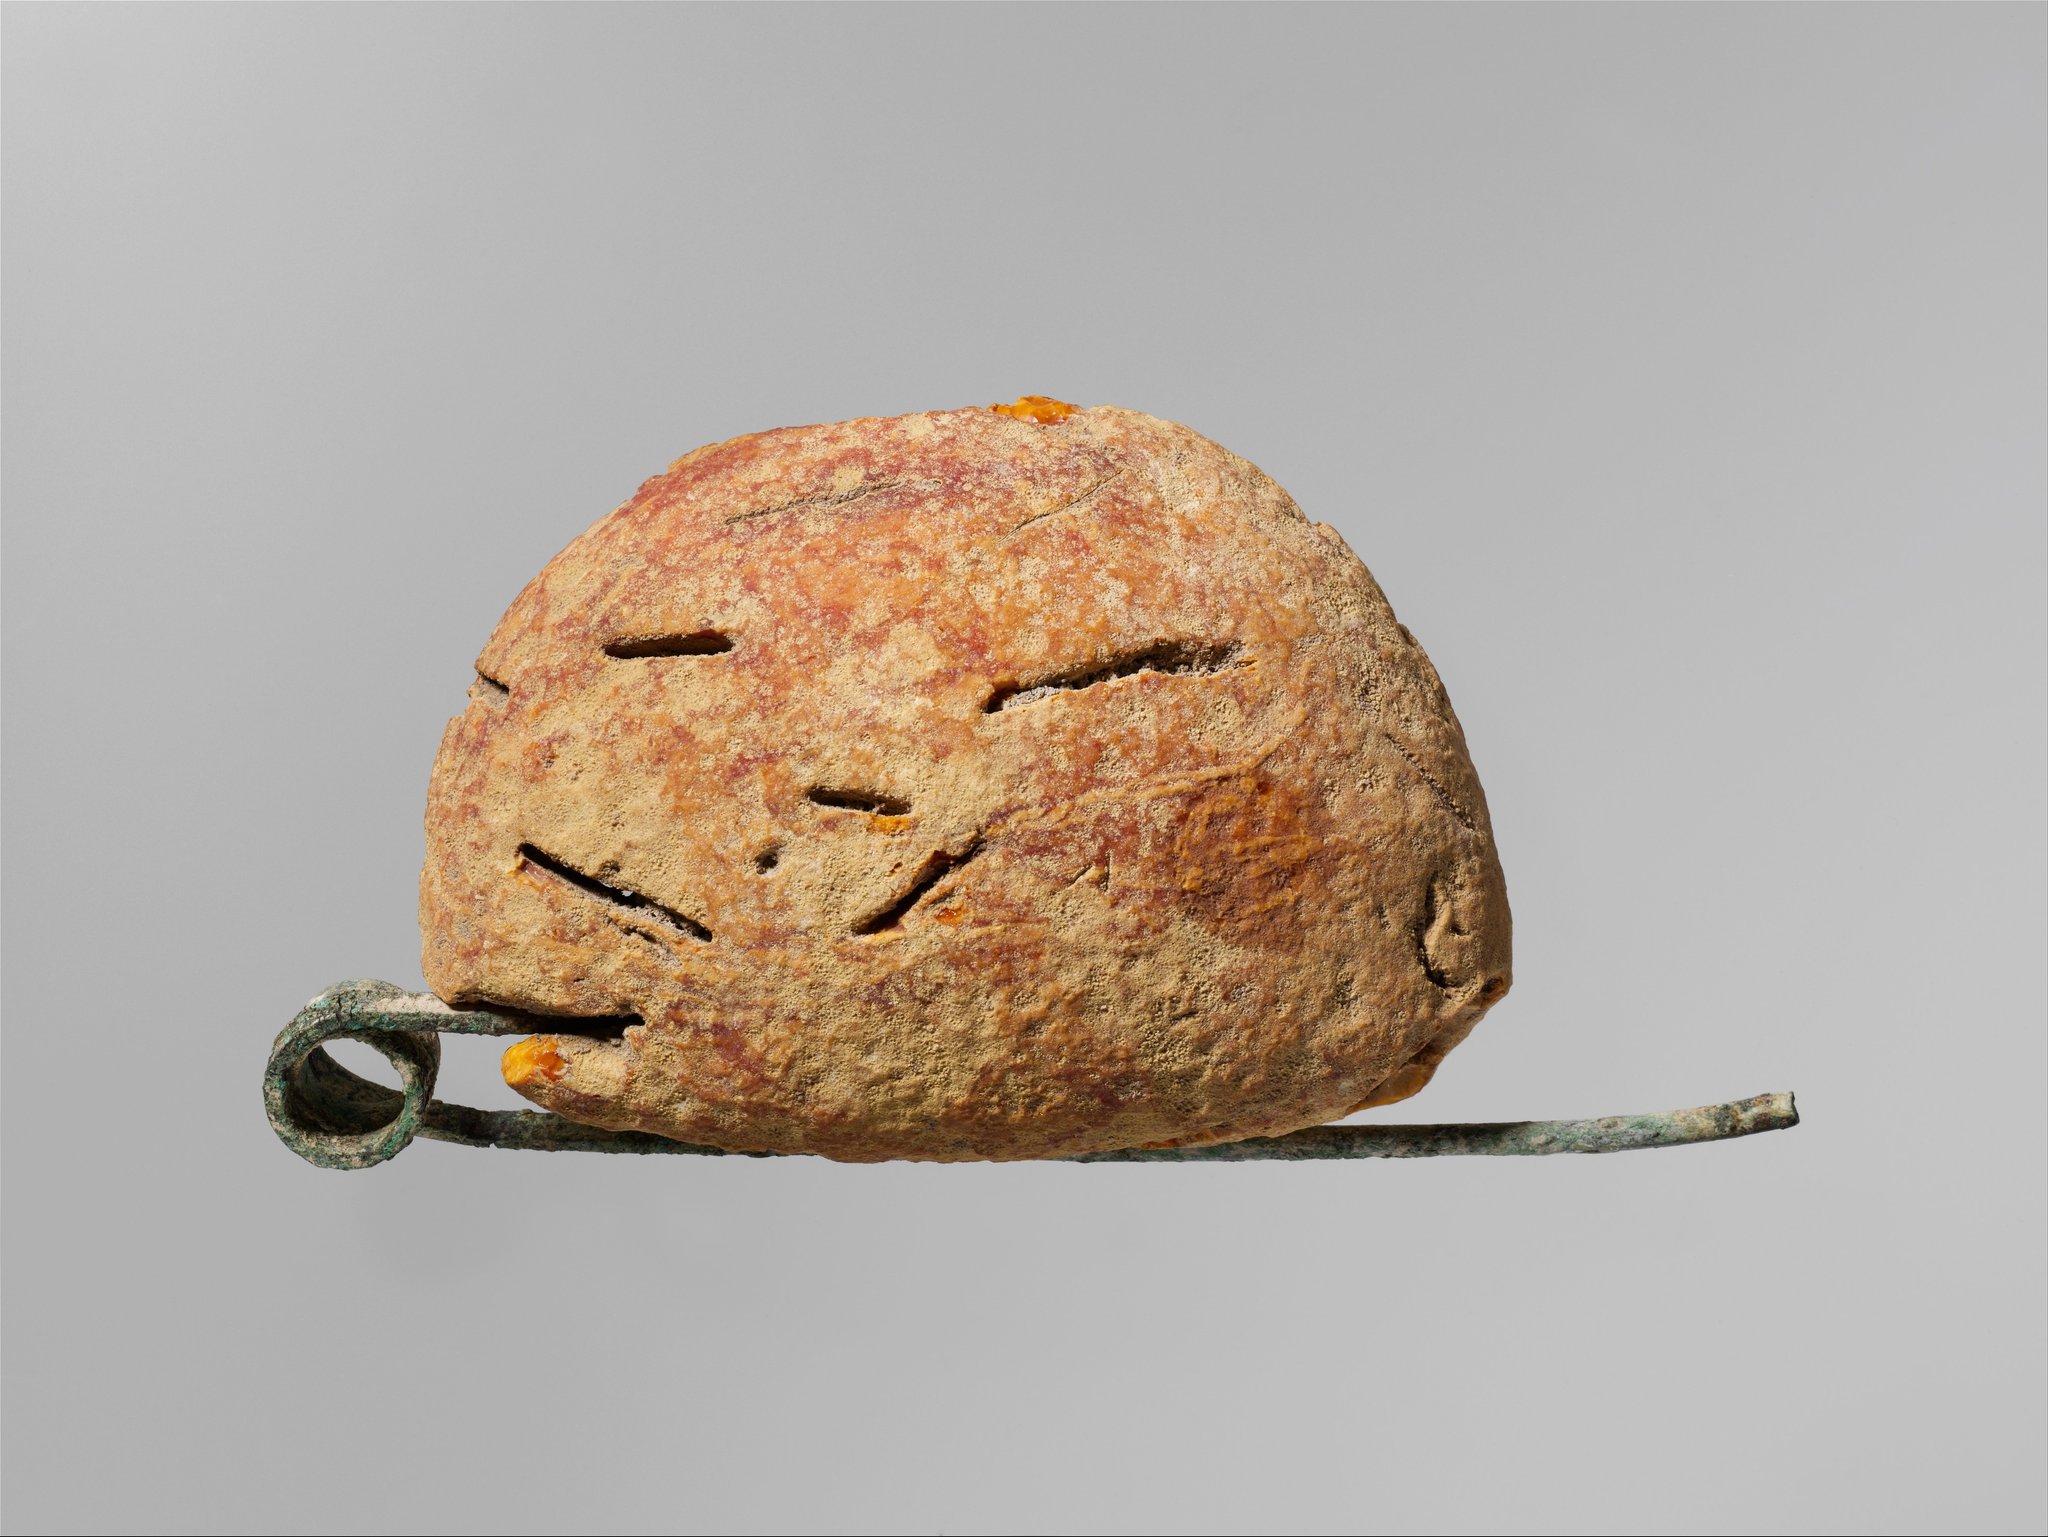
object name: fibula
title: Bronze and amber fibula (safety pin)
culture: etruscan or italic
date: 700-601 BCE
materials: amber